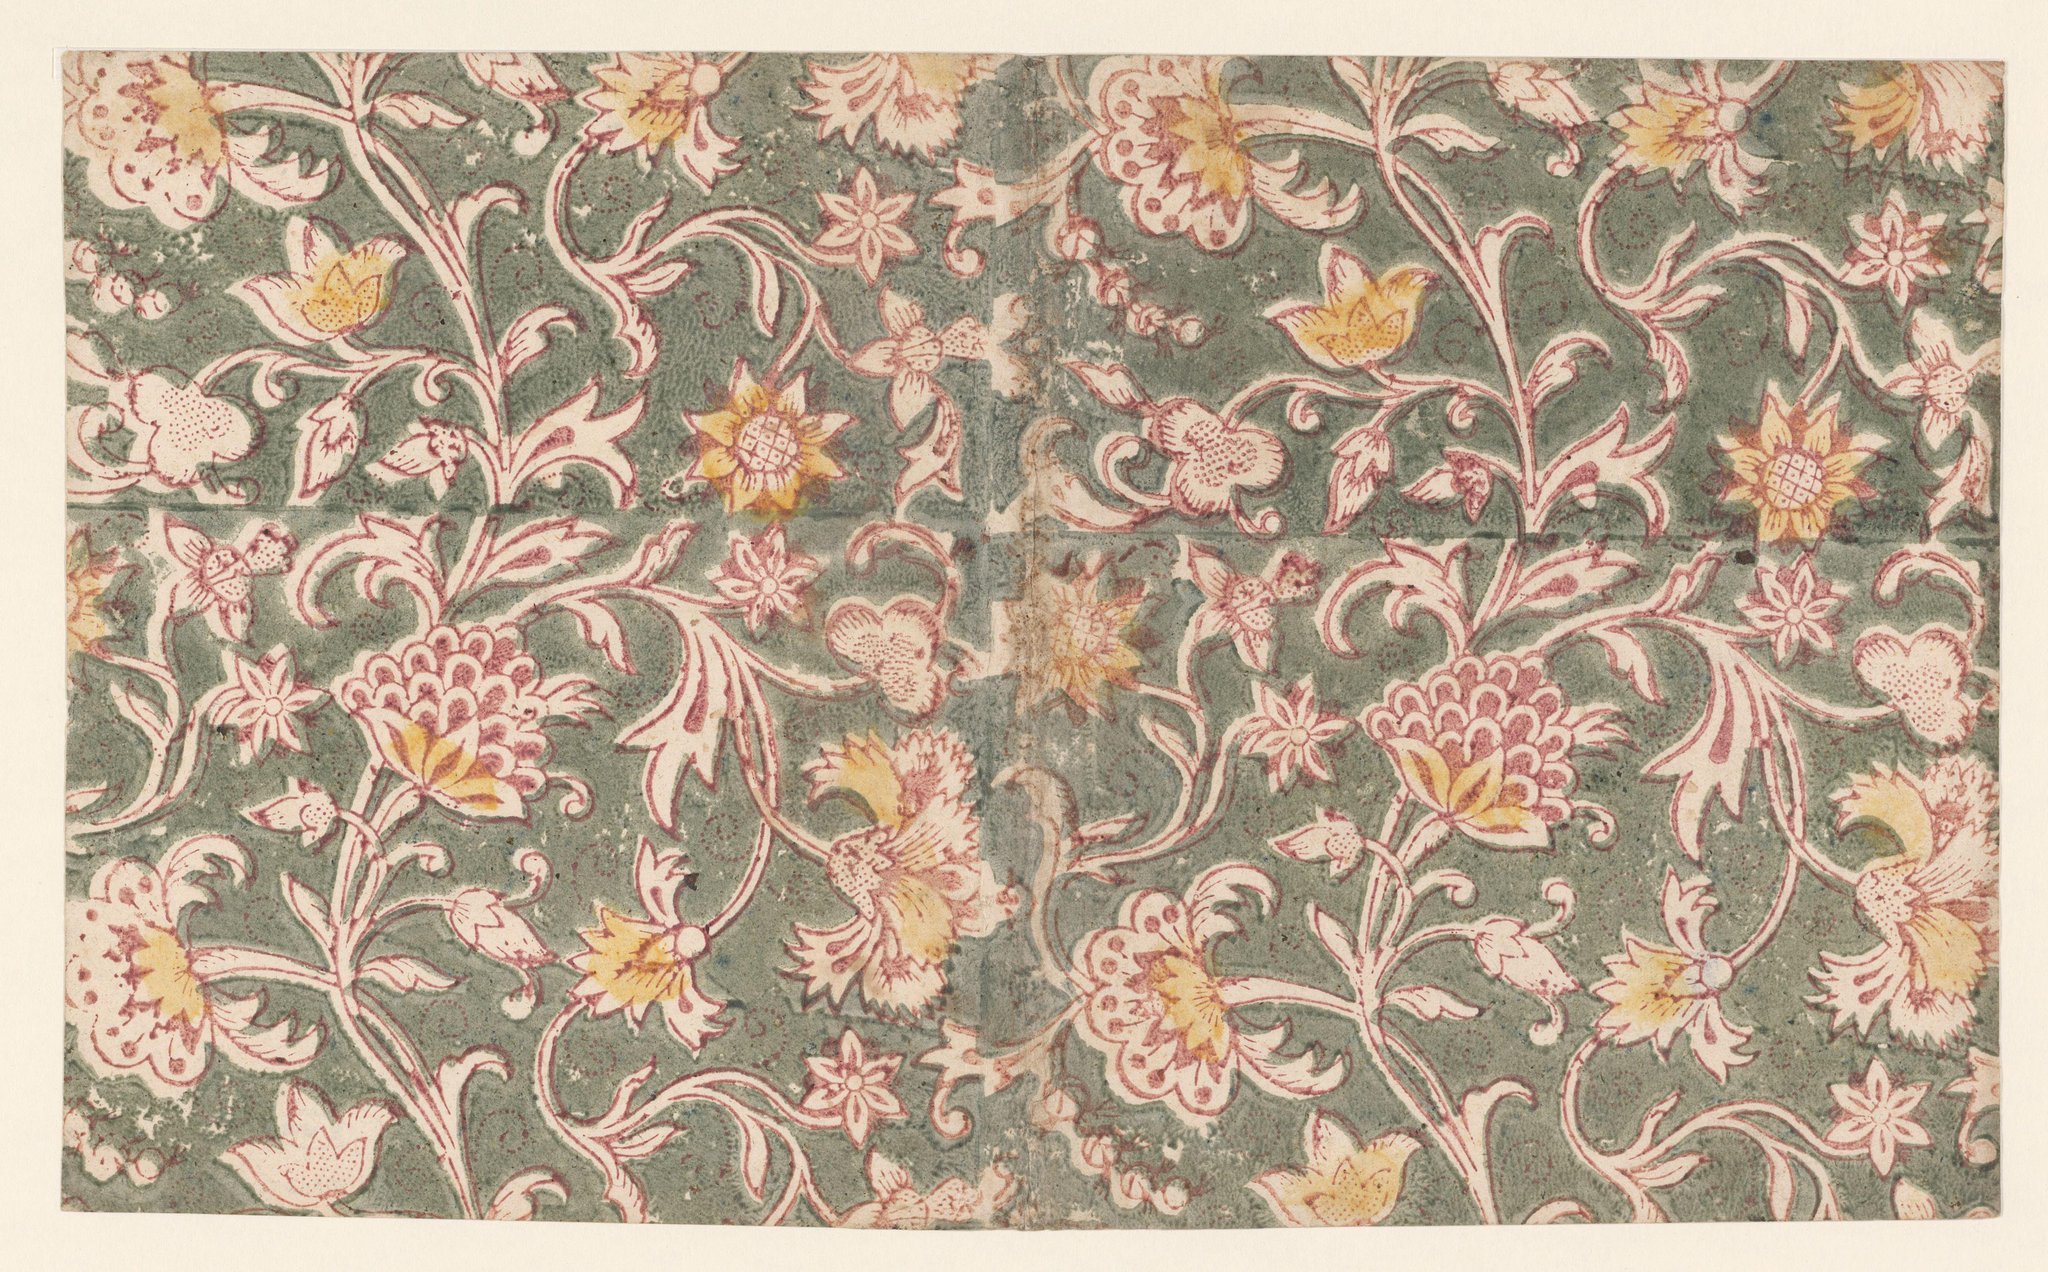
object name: printed paper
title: Blad met strooipatroon van bloemen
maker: Anonymous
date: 1725-1765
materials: paper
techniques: printing block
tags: ornament derived from plant forms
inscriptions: annotation: ‘1745’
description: Blad met strooipatroon van bloemen. Gebruikt als omslag voor een publicatie uit 1745.